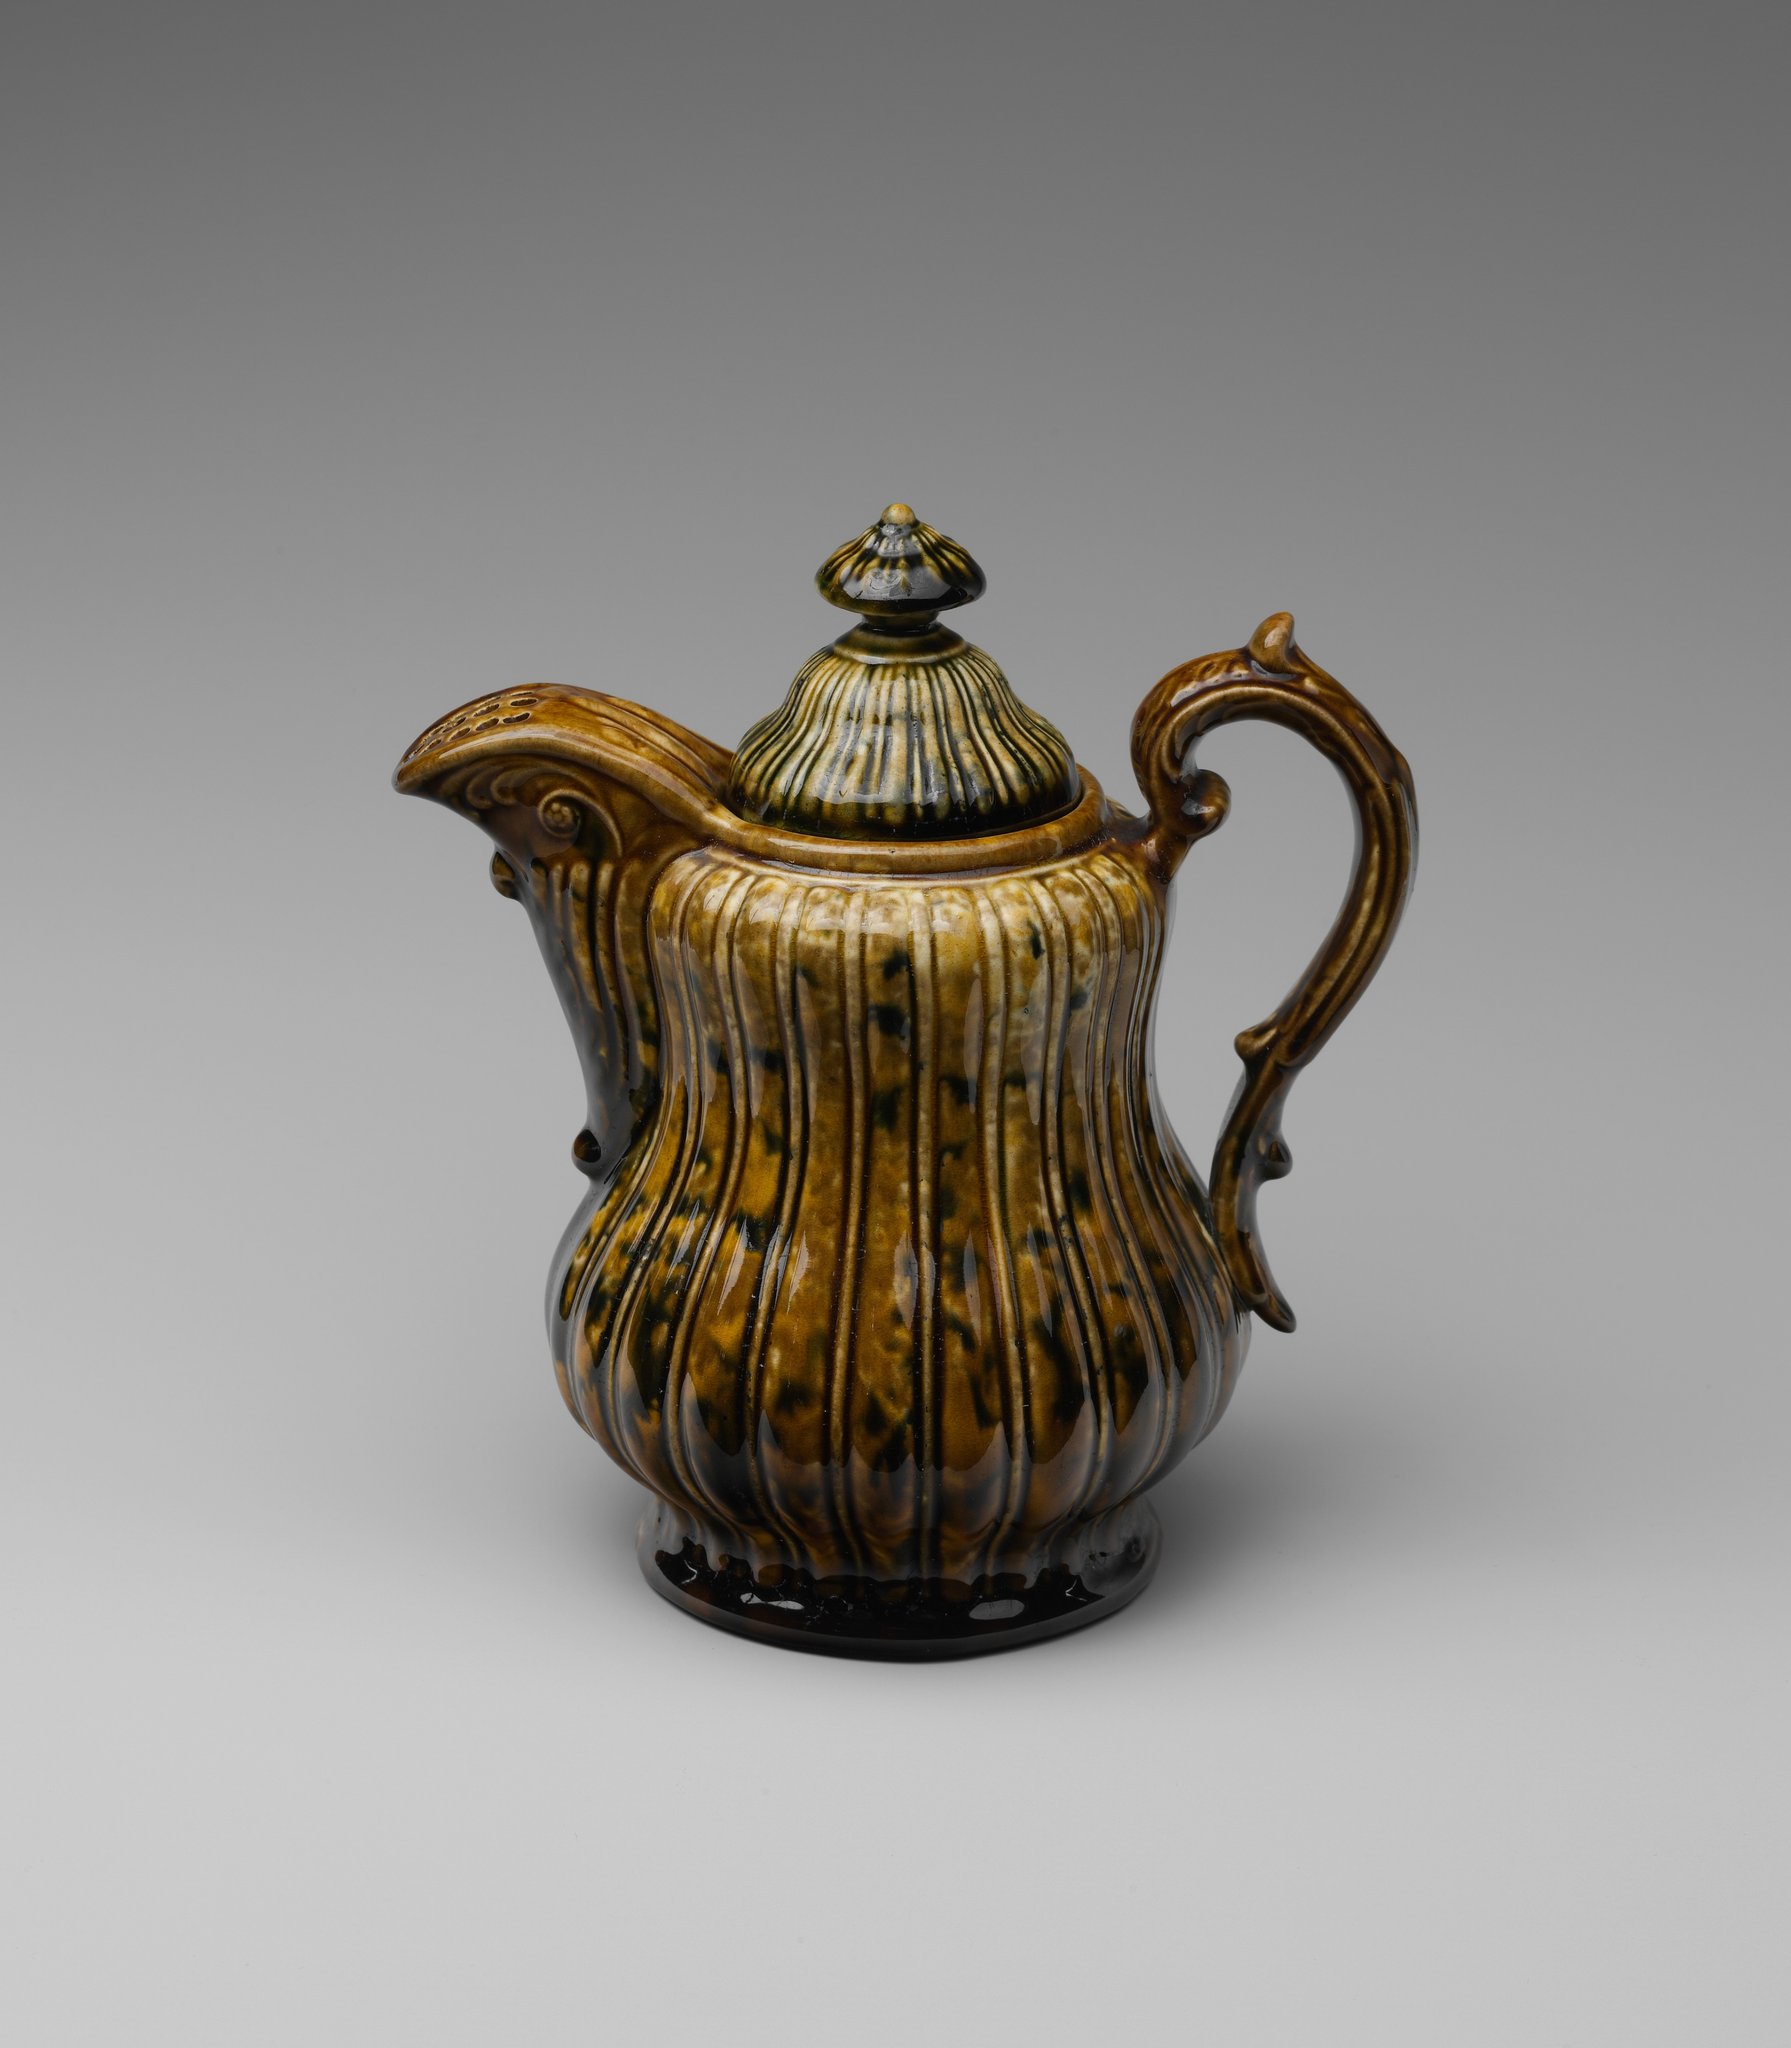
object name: ale pitcher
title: Covered ale pitcher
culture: american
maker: lyman, fenton & co.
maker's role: manufacturer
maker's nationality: american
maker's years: 1849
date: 1849-1852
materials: earthenware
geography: united states